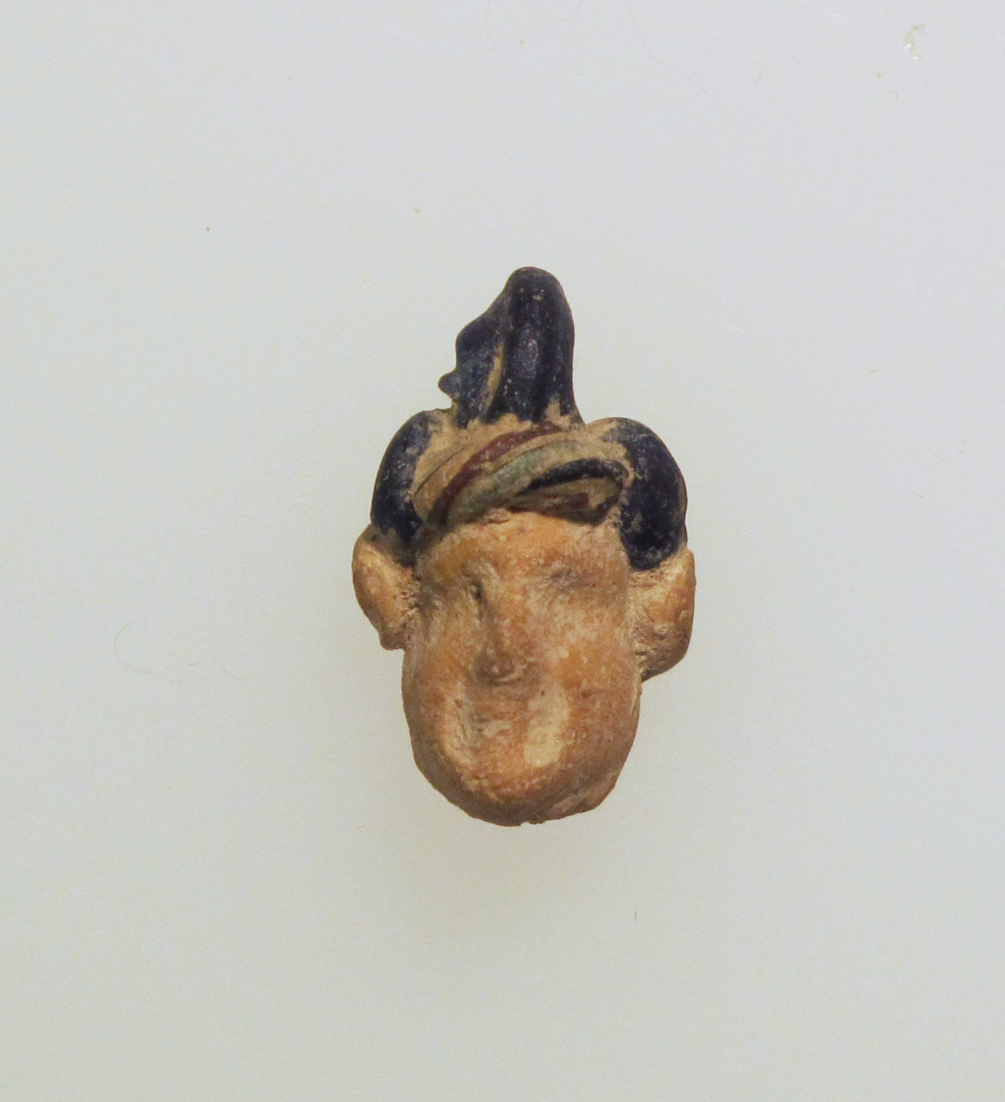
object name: head pendant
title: Glass head pendant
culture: carthaginian or eastern mediterranean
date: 300-1 BCE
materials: glass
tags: heads